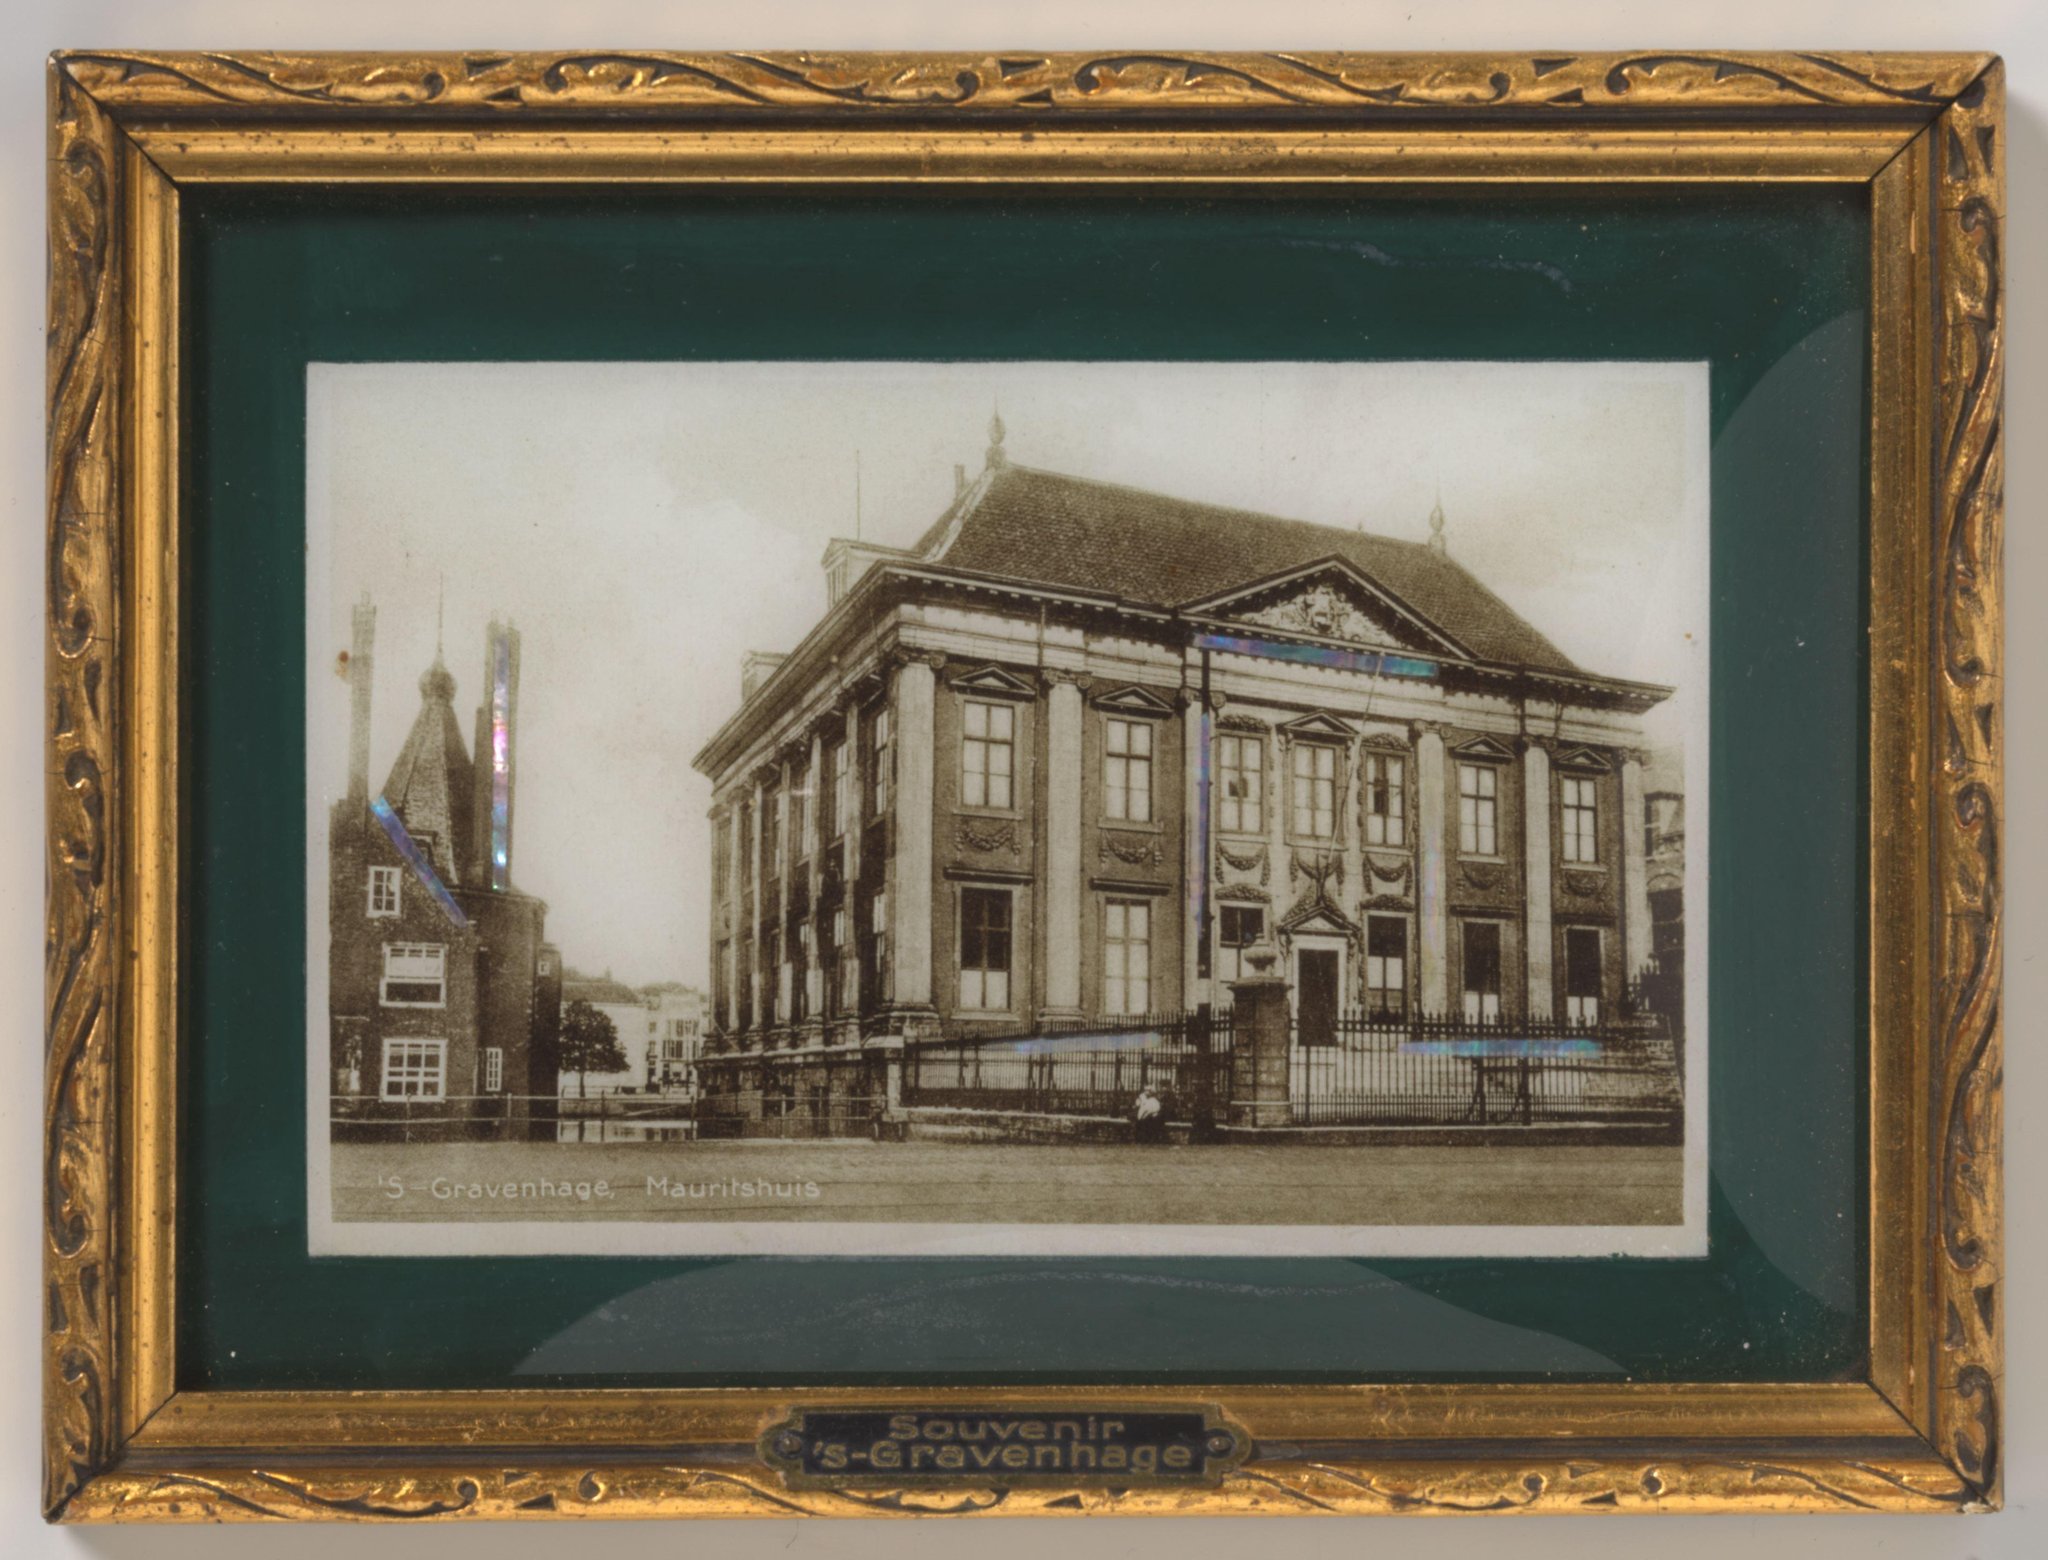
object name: frame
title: 's-Gravenhage, Mauritshuis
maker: Anonymous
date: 1880-1900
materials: cardboard, glass, metal, mother of pearl, paper, wood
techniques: photograph, gilding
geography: the hague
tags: permanent exhibition, museum